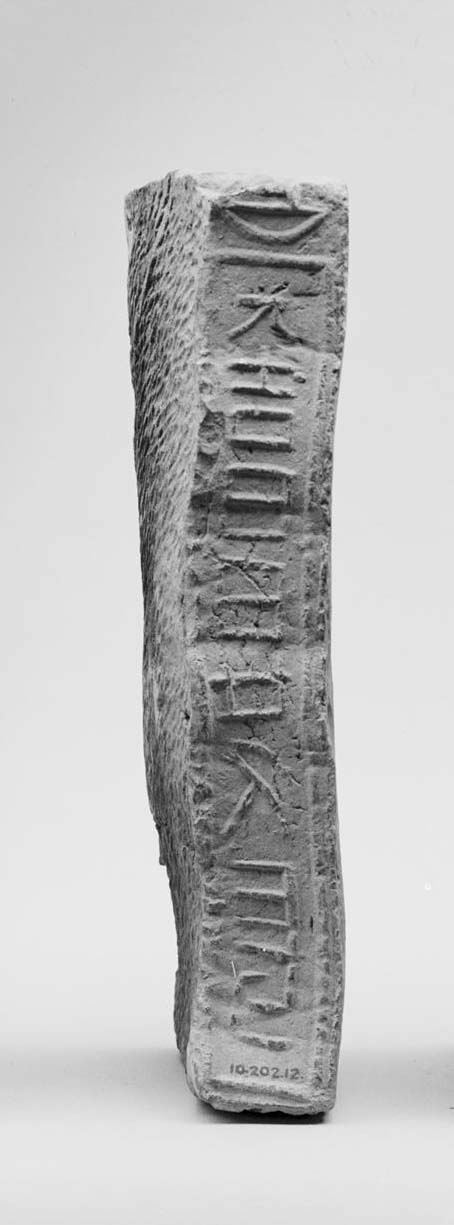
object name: tile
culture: chinese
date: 221 BCE-220 CE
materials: earthenware